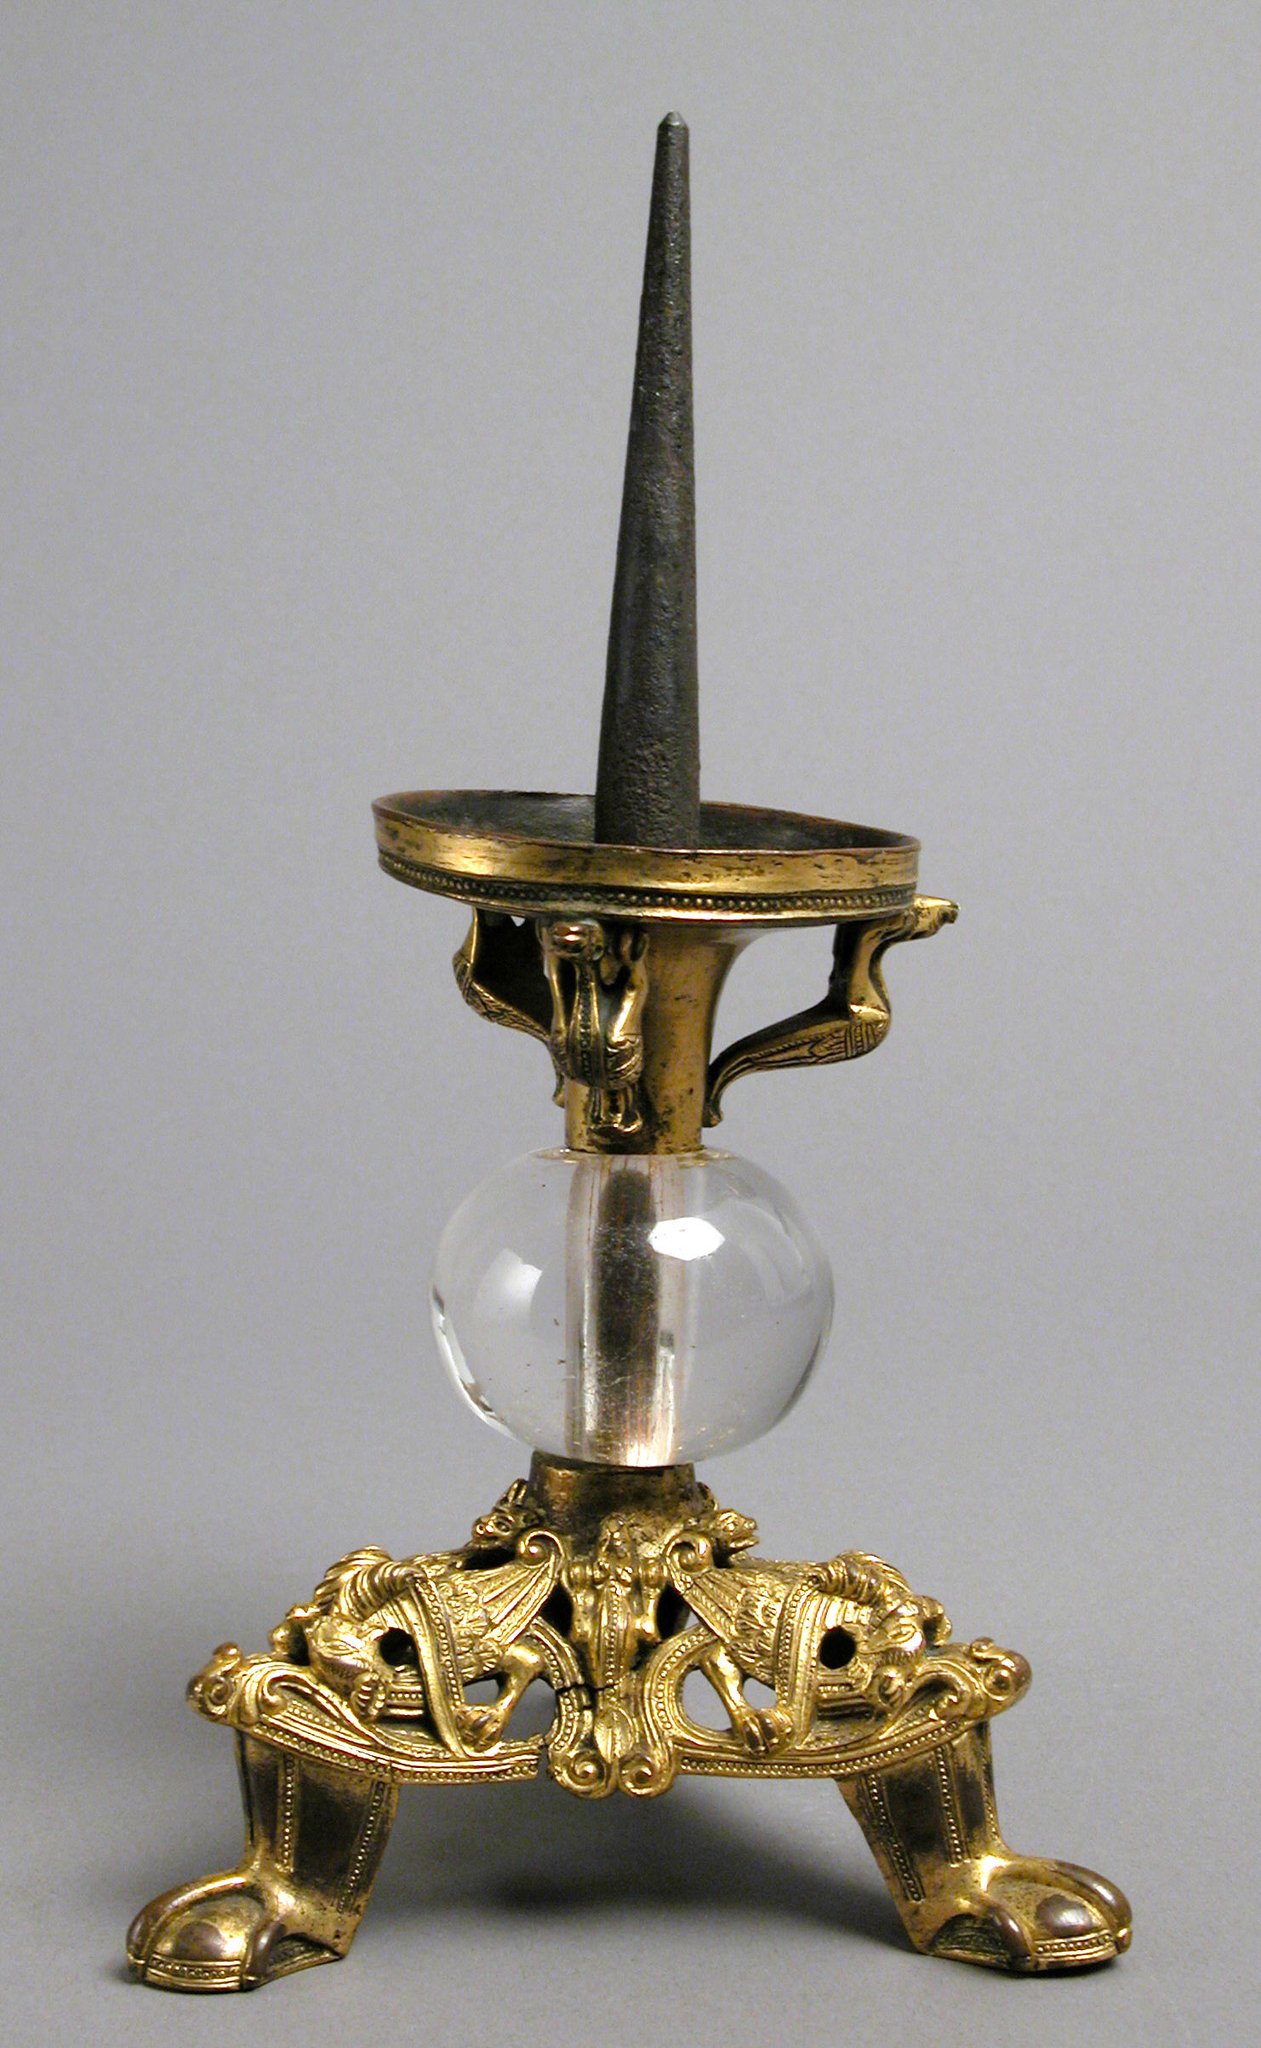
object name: candlestick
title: Pricket Candlestick with Fantastic Creatures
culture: south netherlandish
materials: copper alloy, gilt, quartz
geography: south netherlands